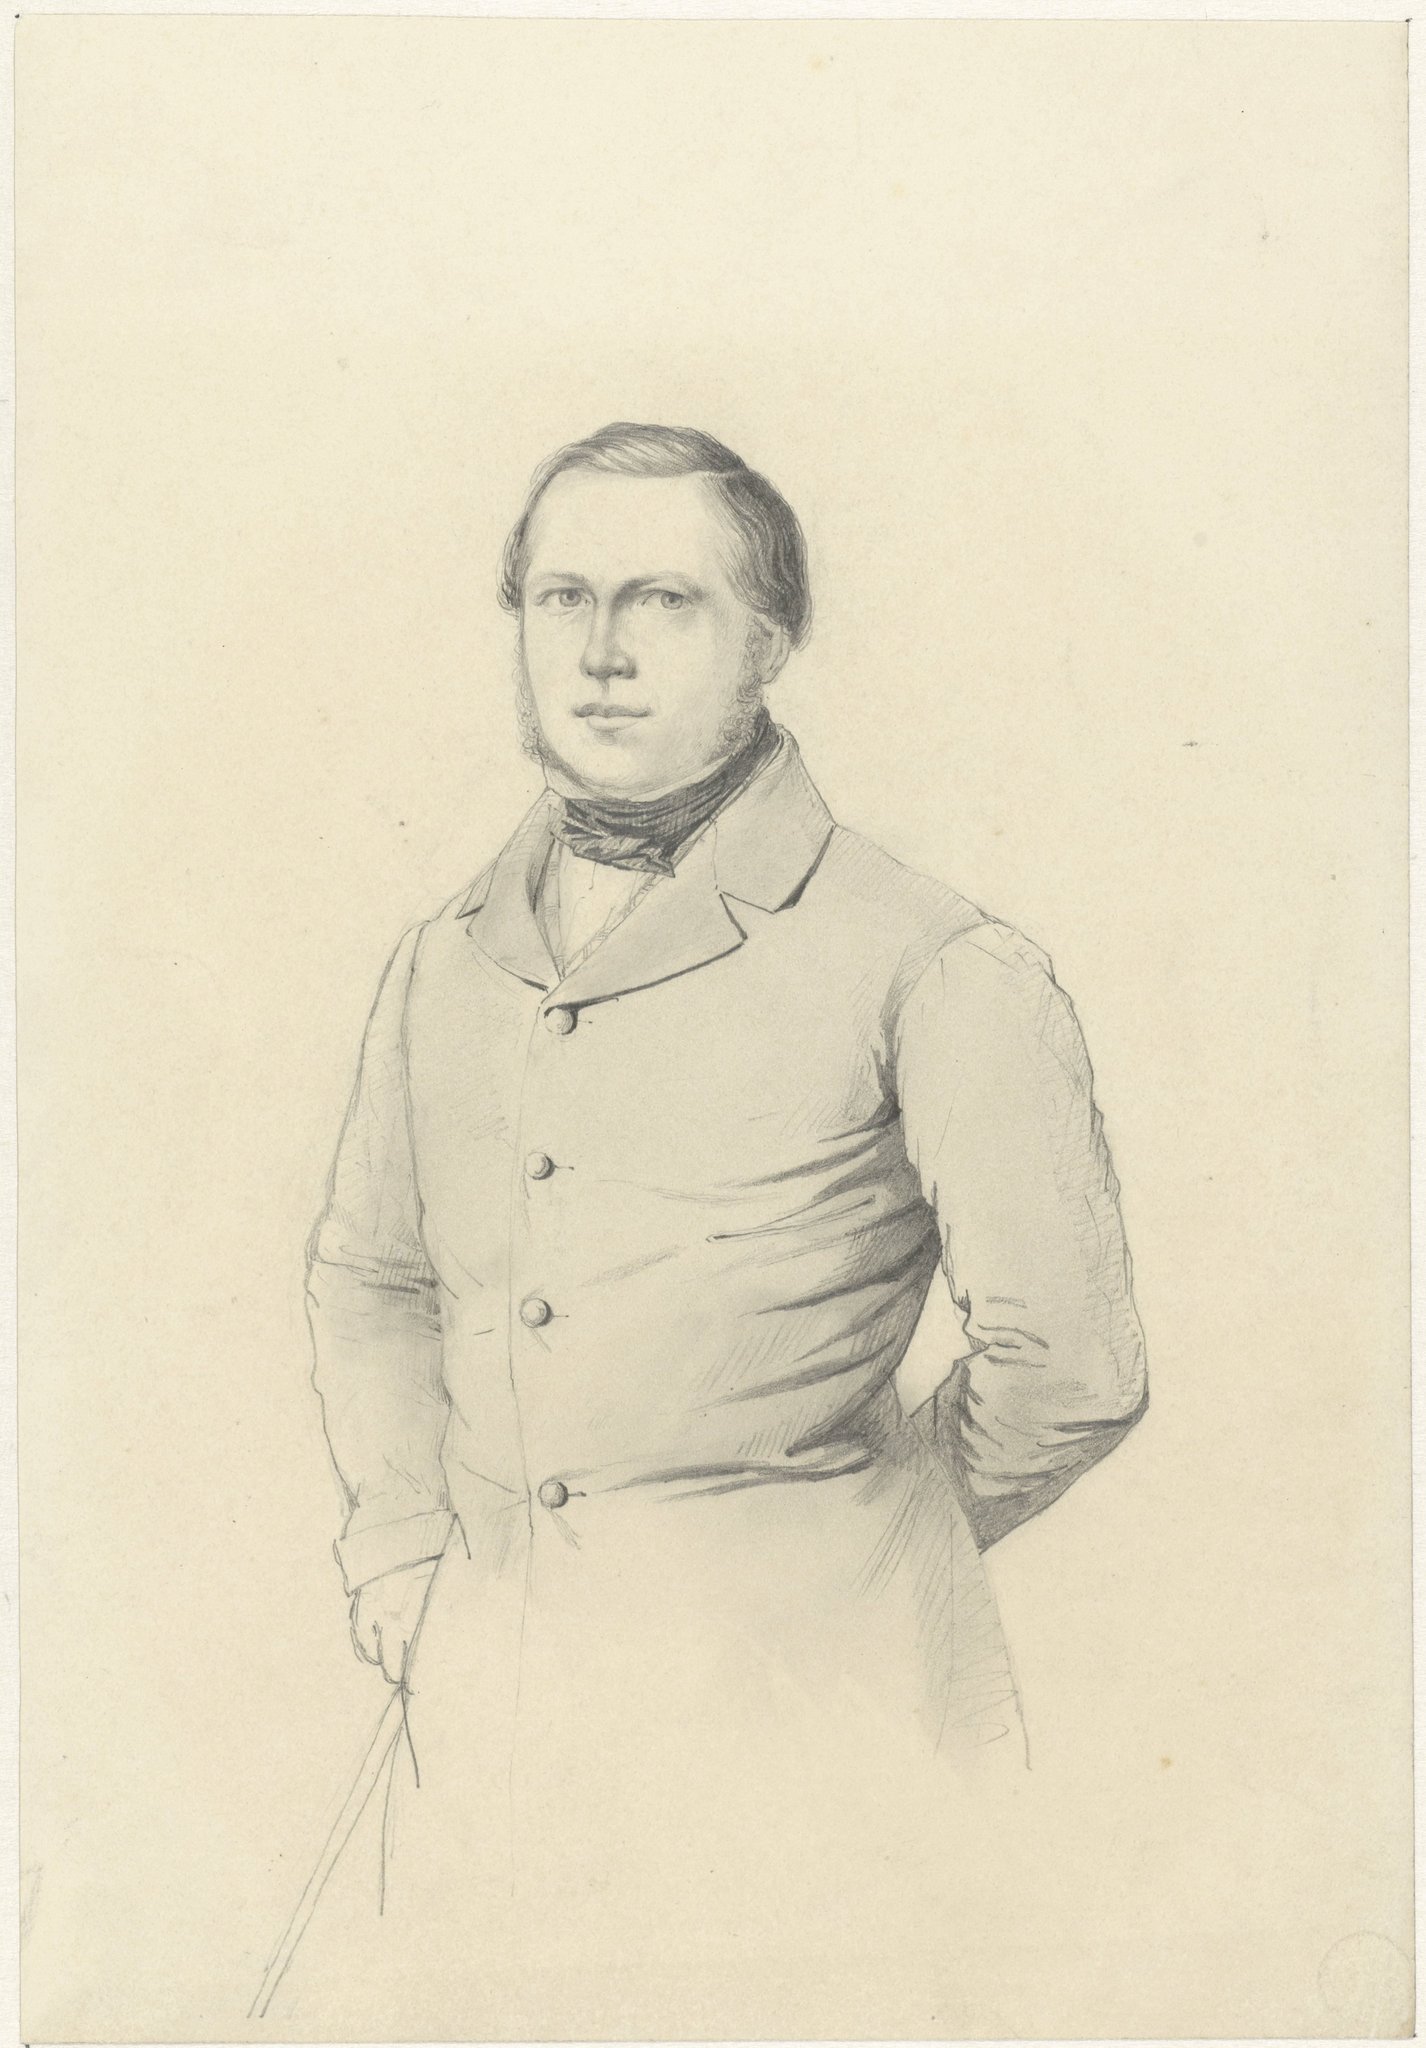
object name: drawing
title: Portret van Nicolaas Beets (?)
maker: giovanni caramelli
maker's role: draughtsman, print maker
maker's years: 1816-1881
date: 1826-1881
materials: paper, pencil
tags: haarlem, utrecht, nicolaas beets, anonymous historical person portrayed alone, historical persons